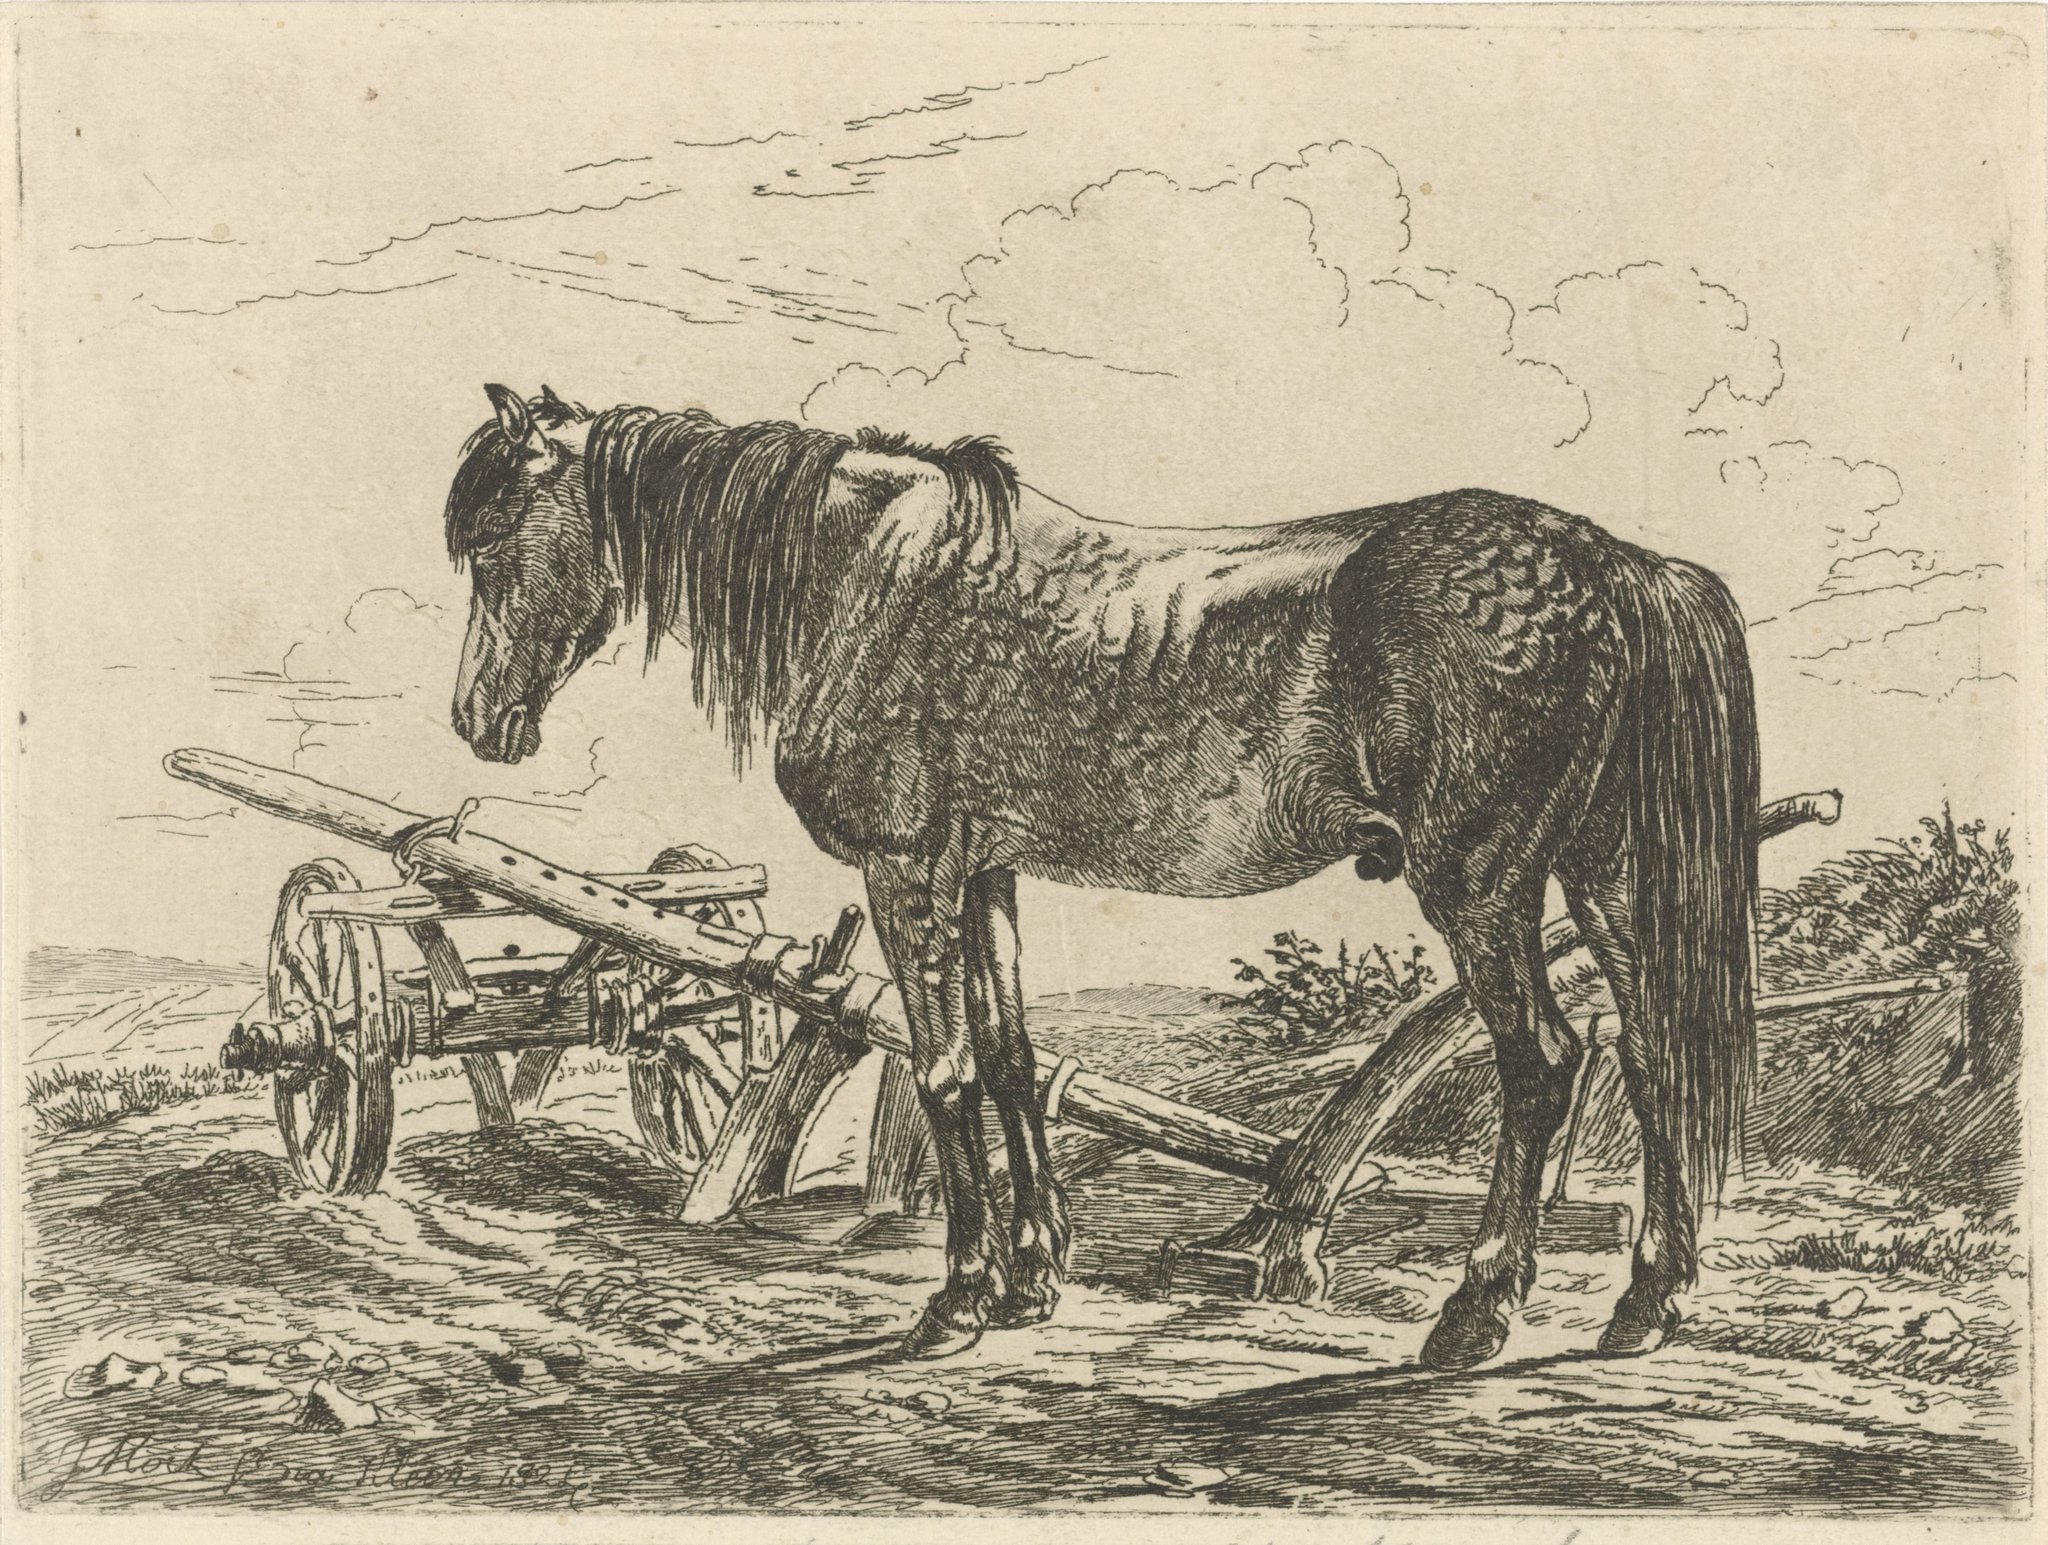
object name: print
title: Paard bij een ploeg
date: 1824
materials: paper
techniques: drypoint, etching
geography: netherlands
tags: horse, agricultural implements: plough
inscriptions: collector's mark: Lugt 2228